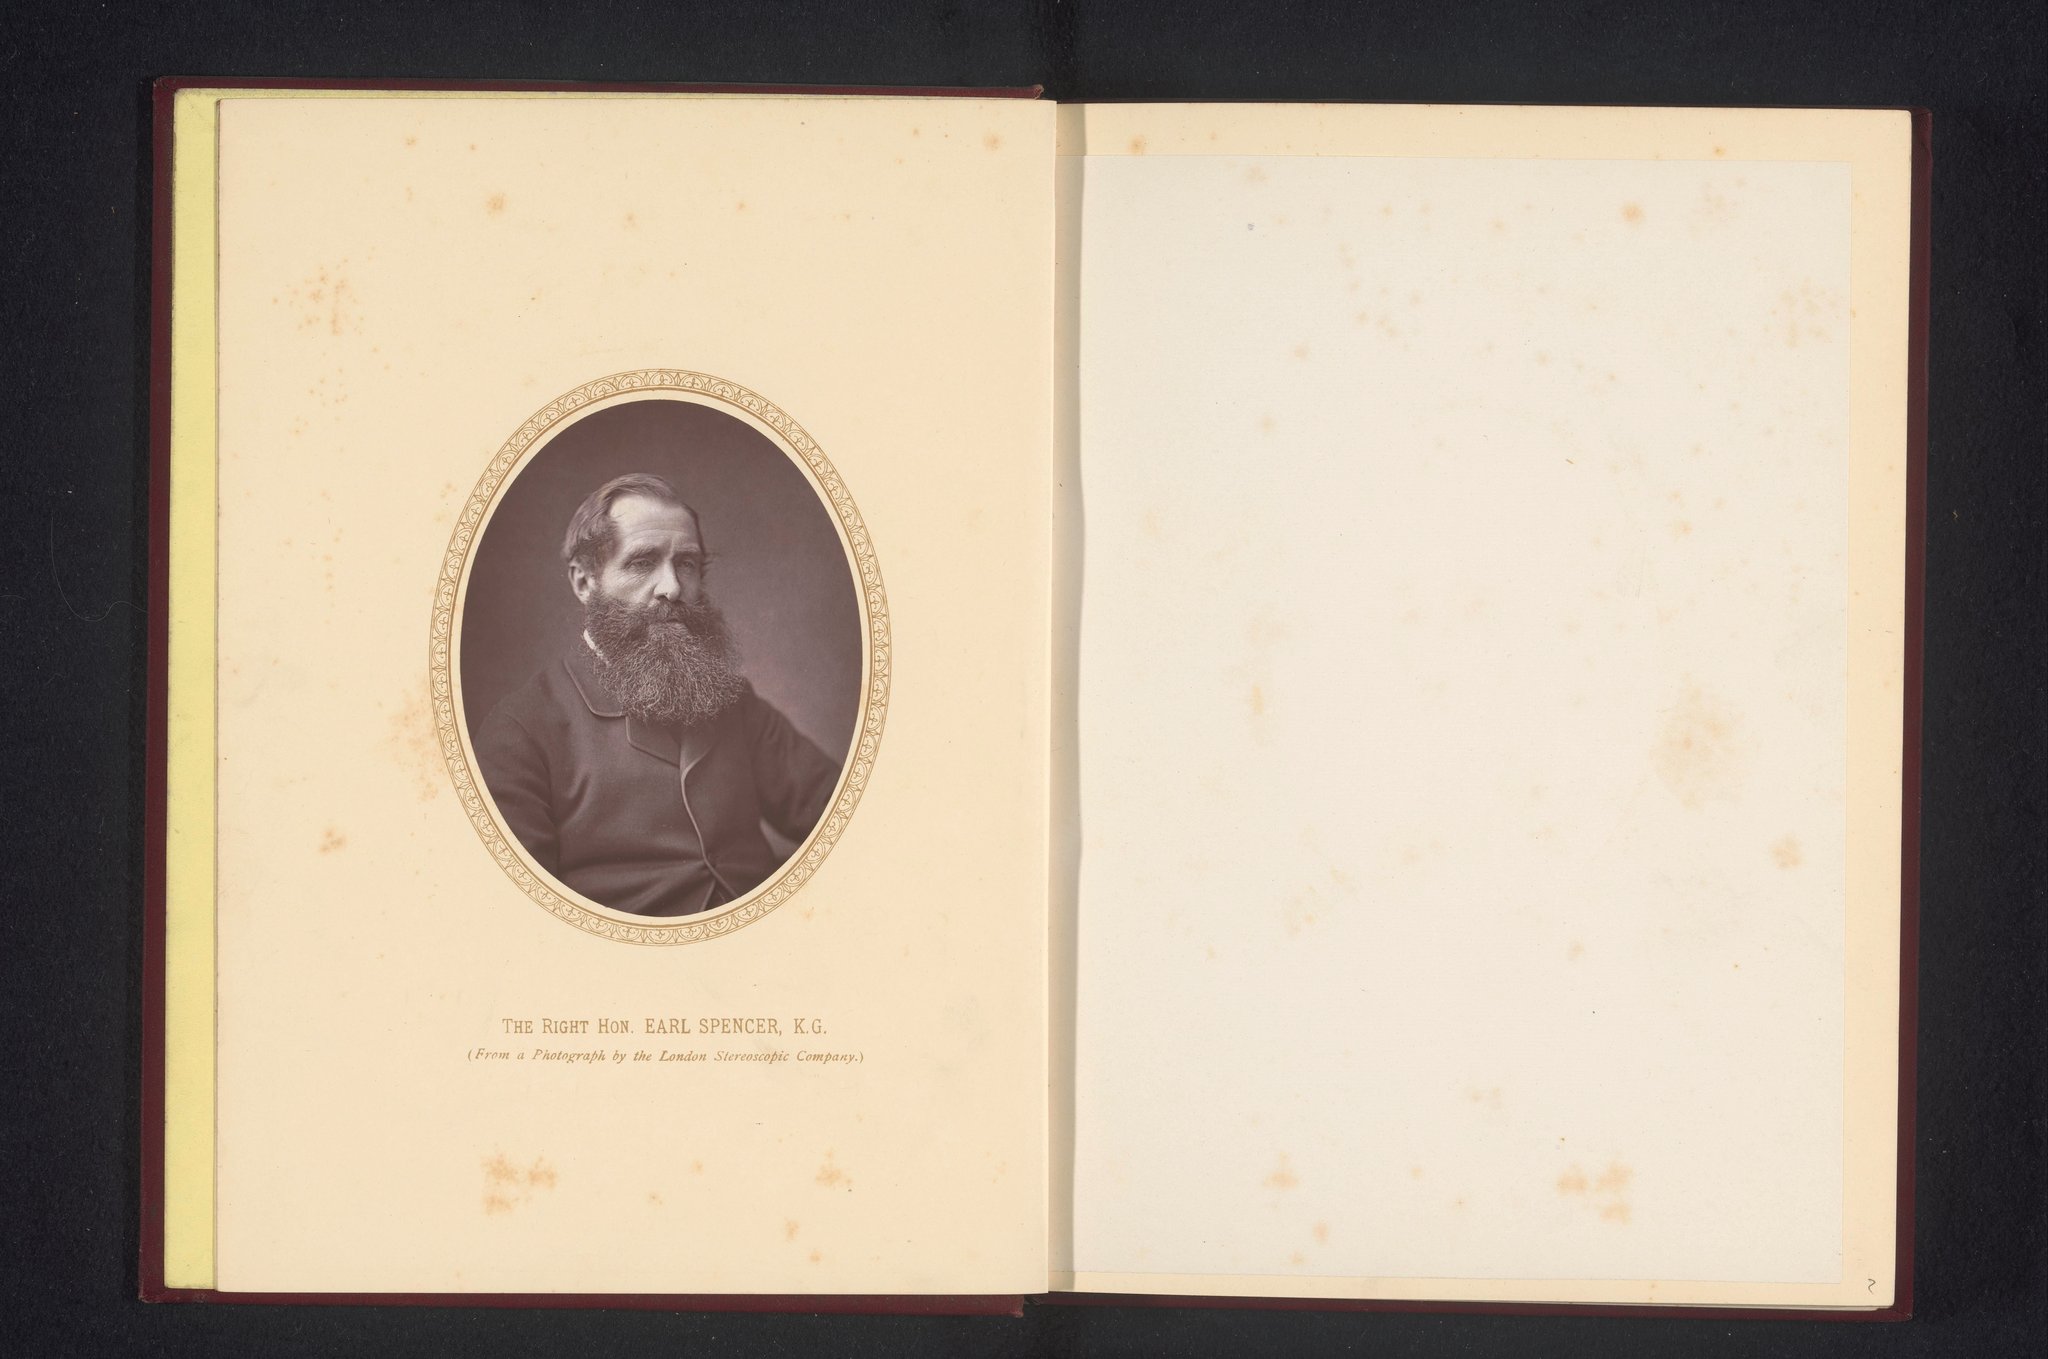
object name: page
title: The right hon. Earl Spencer K.G.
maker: Anonymous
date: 1875-1880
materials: paper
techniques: woodburytype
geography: london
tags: politician, e.g. party leader